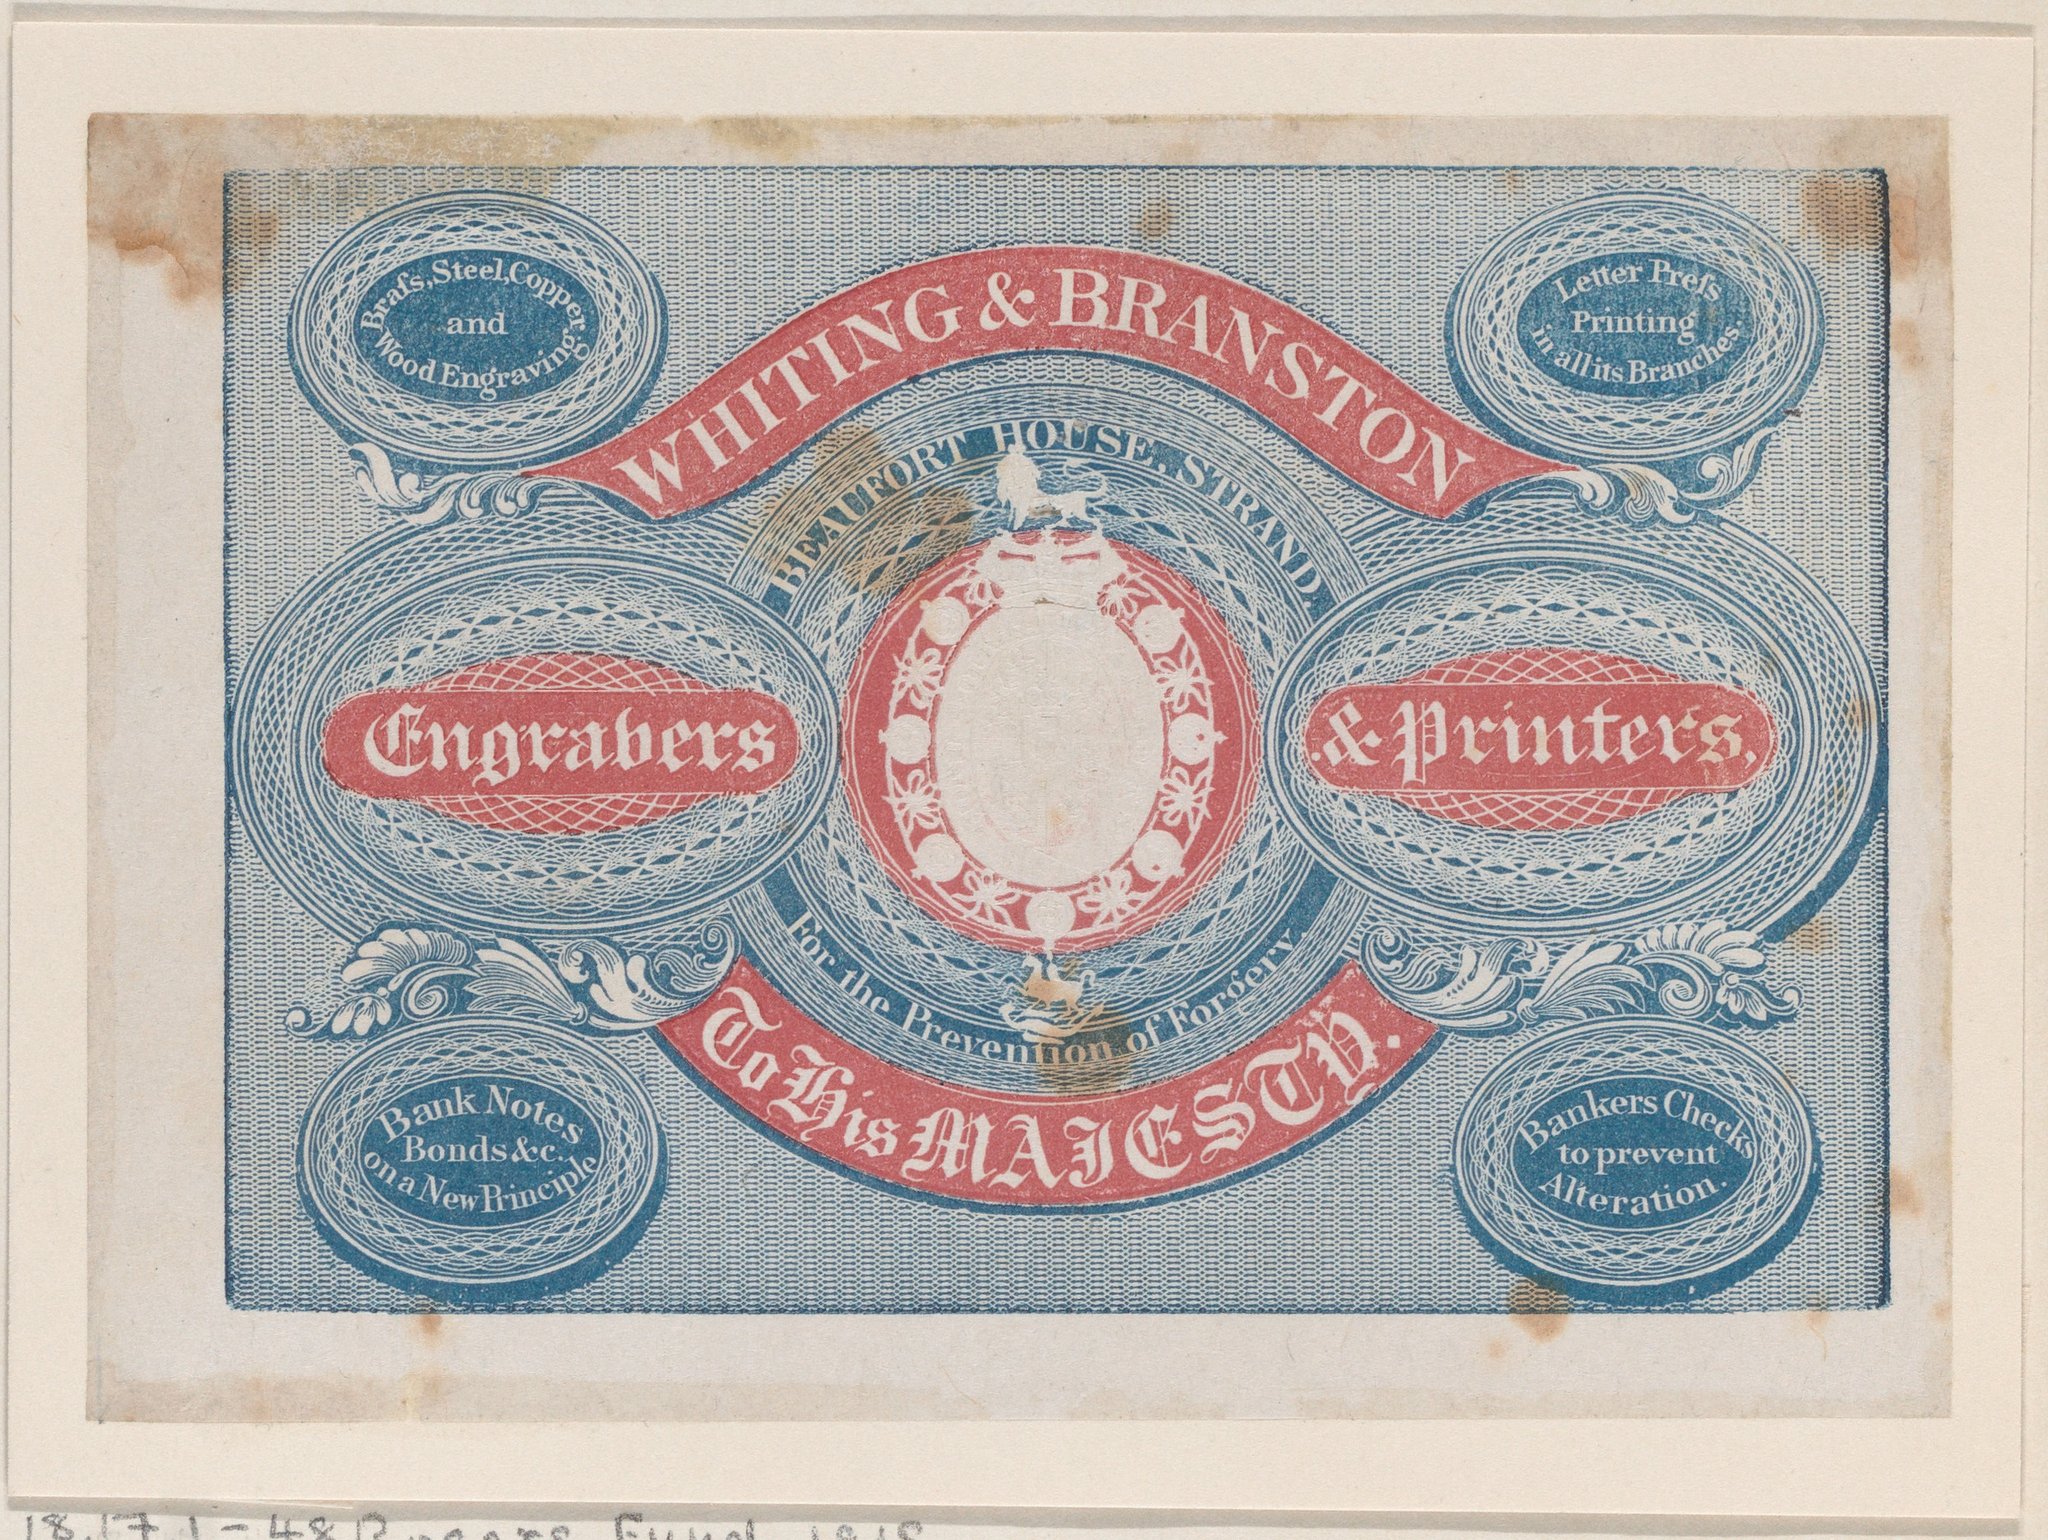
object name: print, trade card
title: Trade Card for Whiting & Branston, Engravers & Printers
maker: anonymous, british, 19th century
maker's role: artist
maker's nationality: british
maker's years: 1800-1900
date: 1801-1900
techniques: engraving